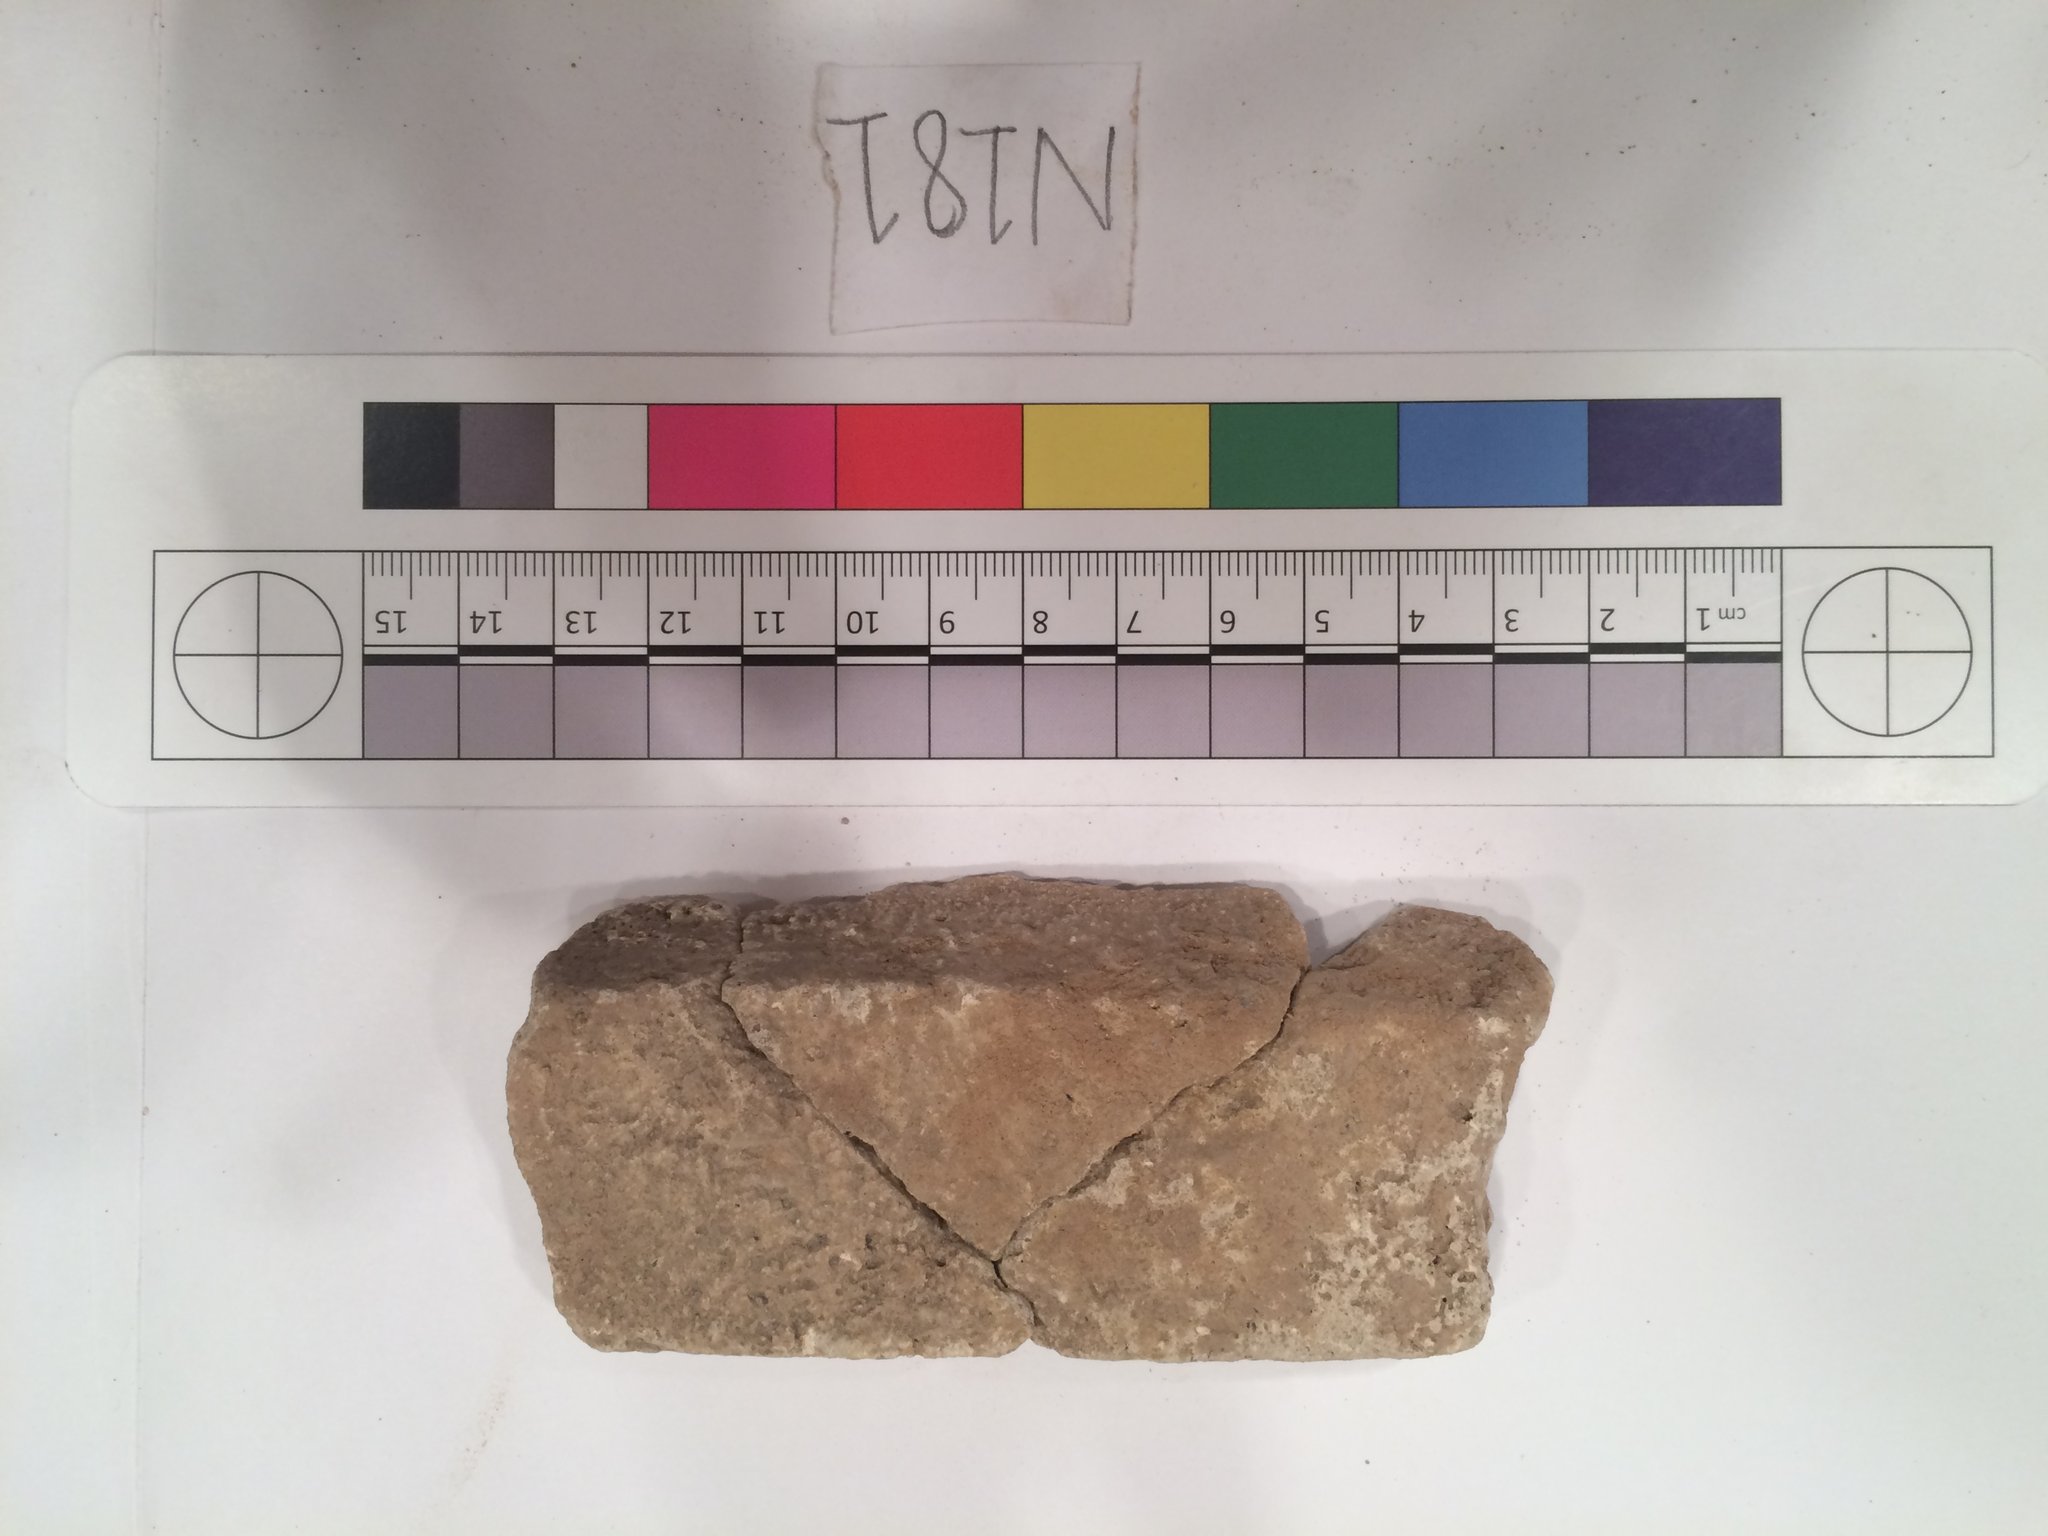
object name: fragment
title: Stucco Fragment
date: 701-1200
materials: plaster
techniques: carving, painting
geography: iran